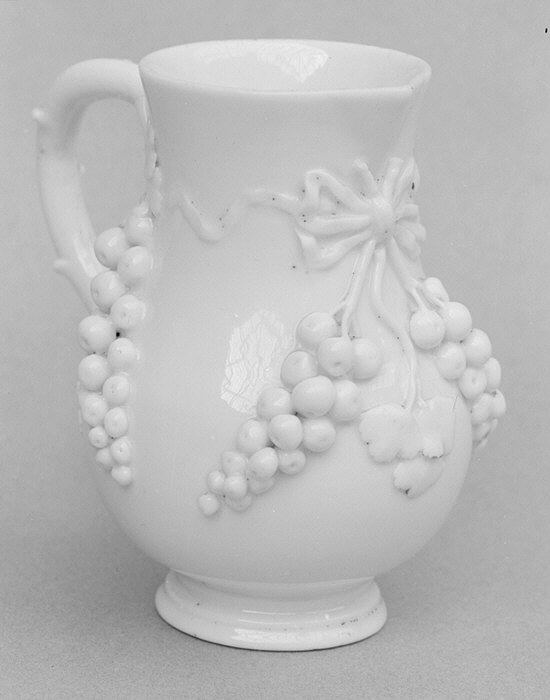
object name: cream jug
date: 1750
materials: soft paste porcelain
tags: grapes